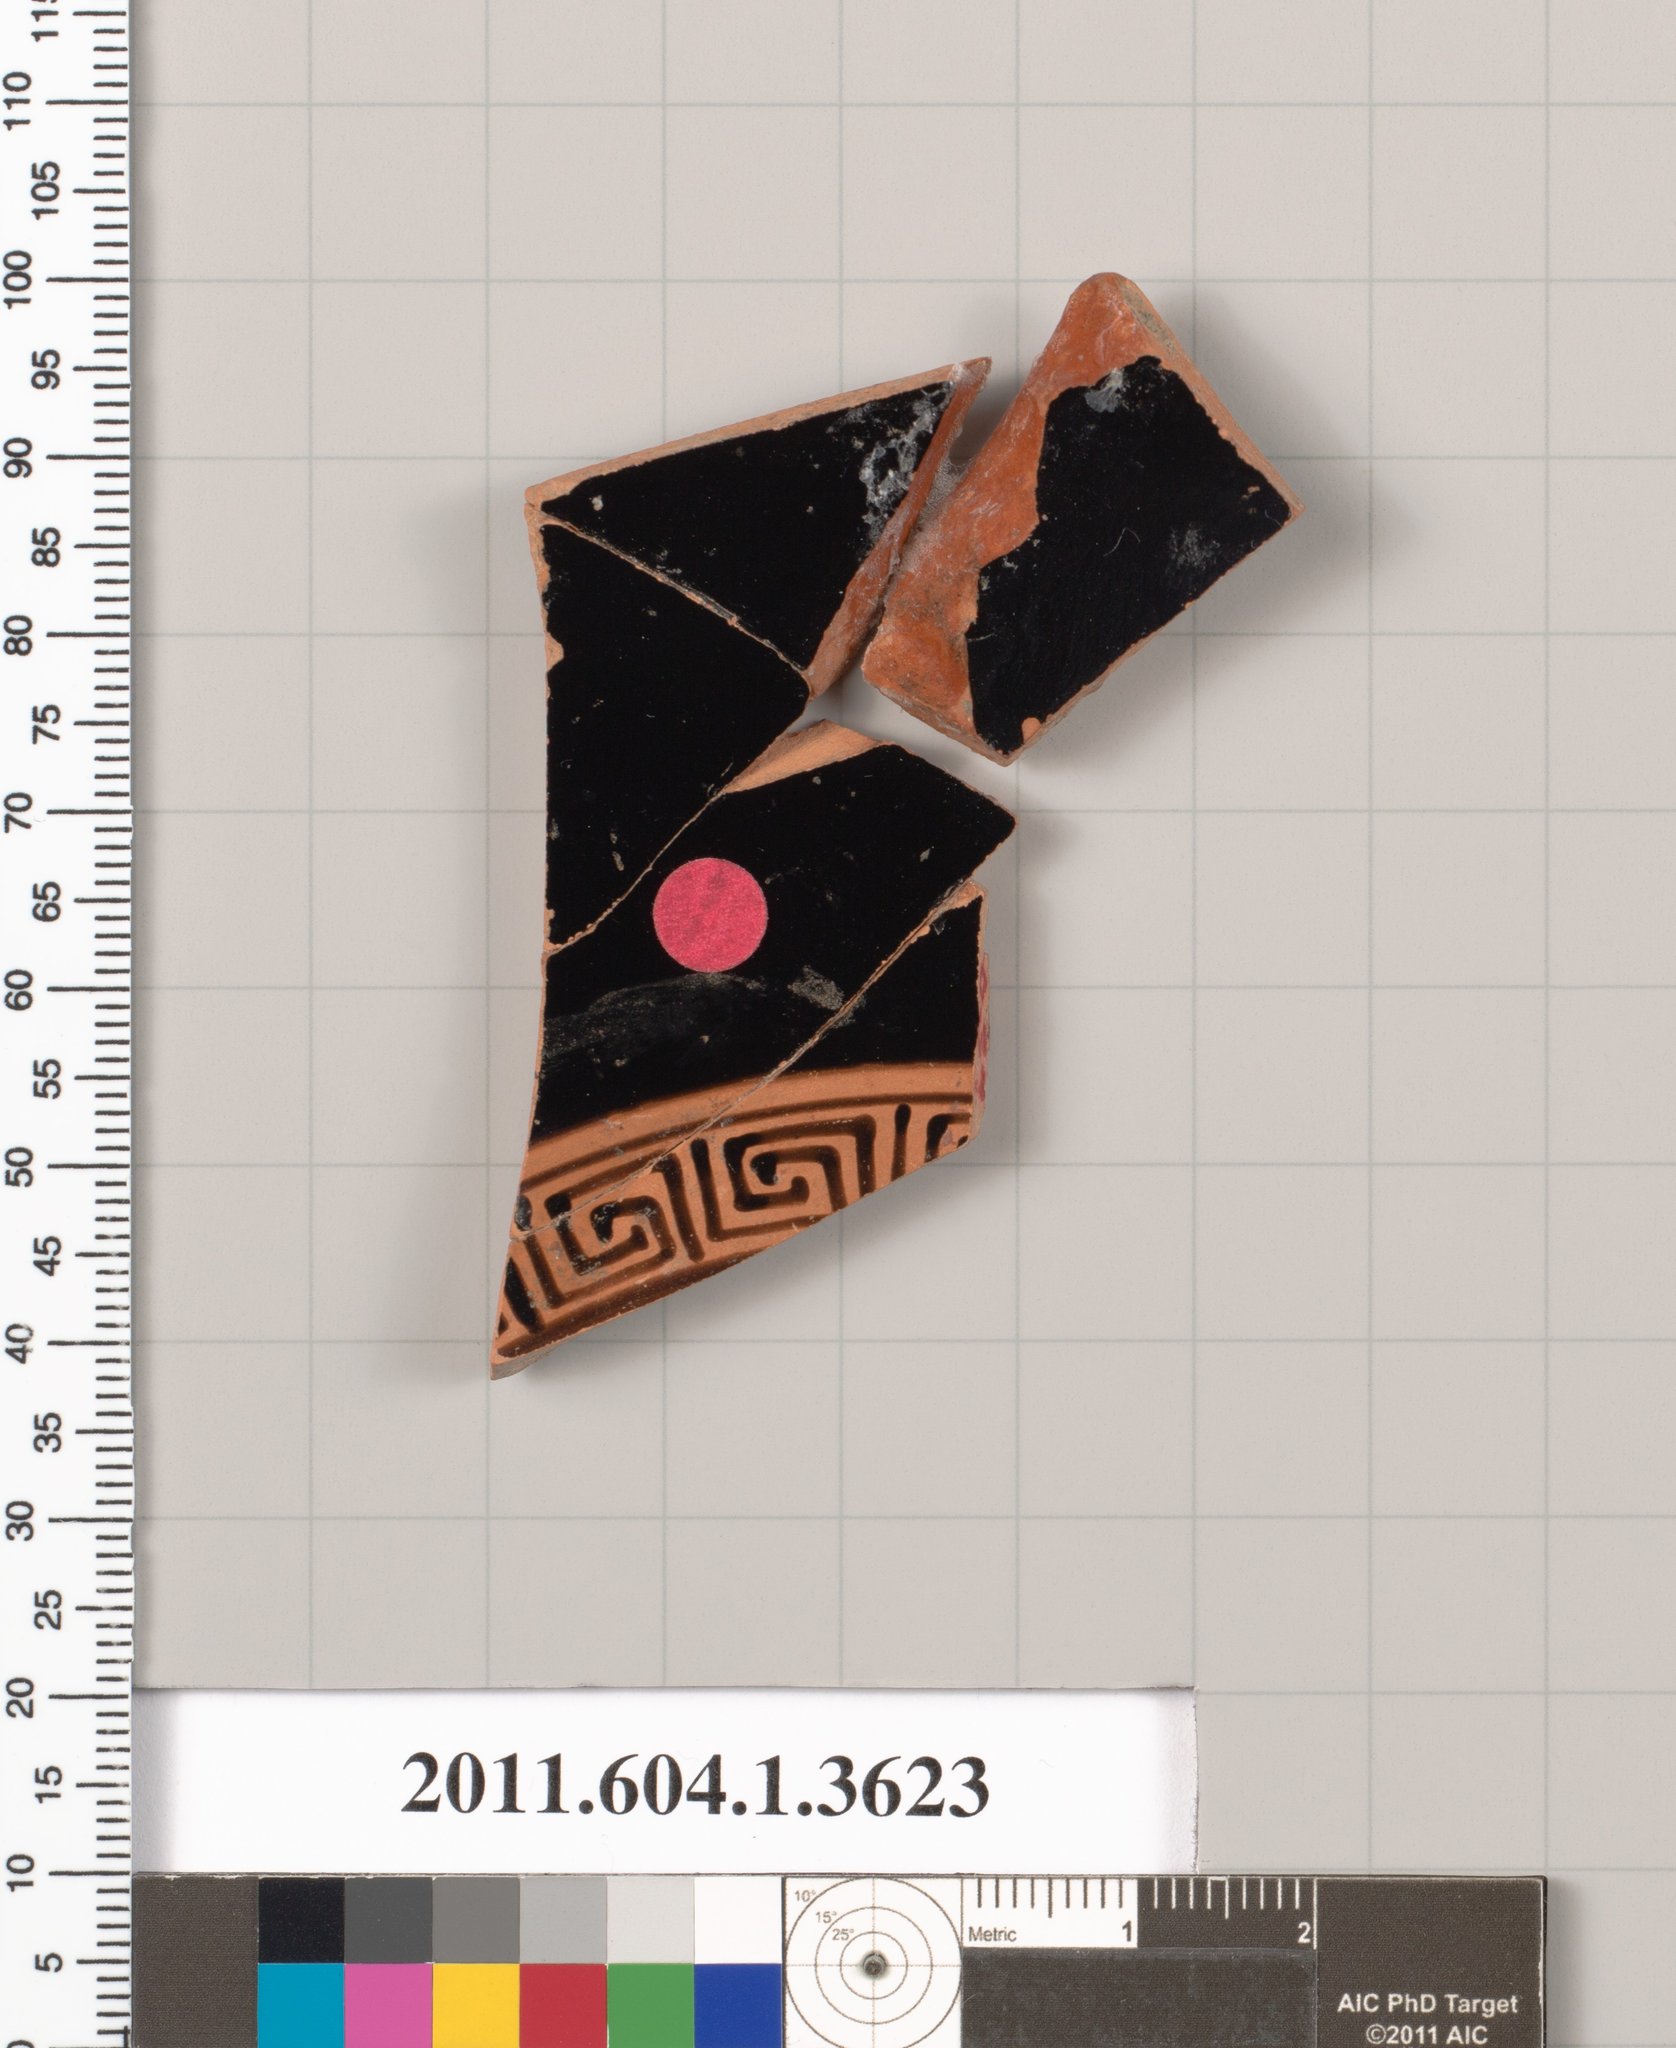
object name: kylix fragment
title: Terracotta fragment of a kylix (drinking cup)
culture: greek, attic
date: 475-451 BCE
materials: terracotta